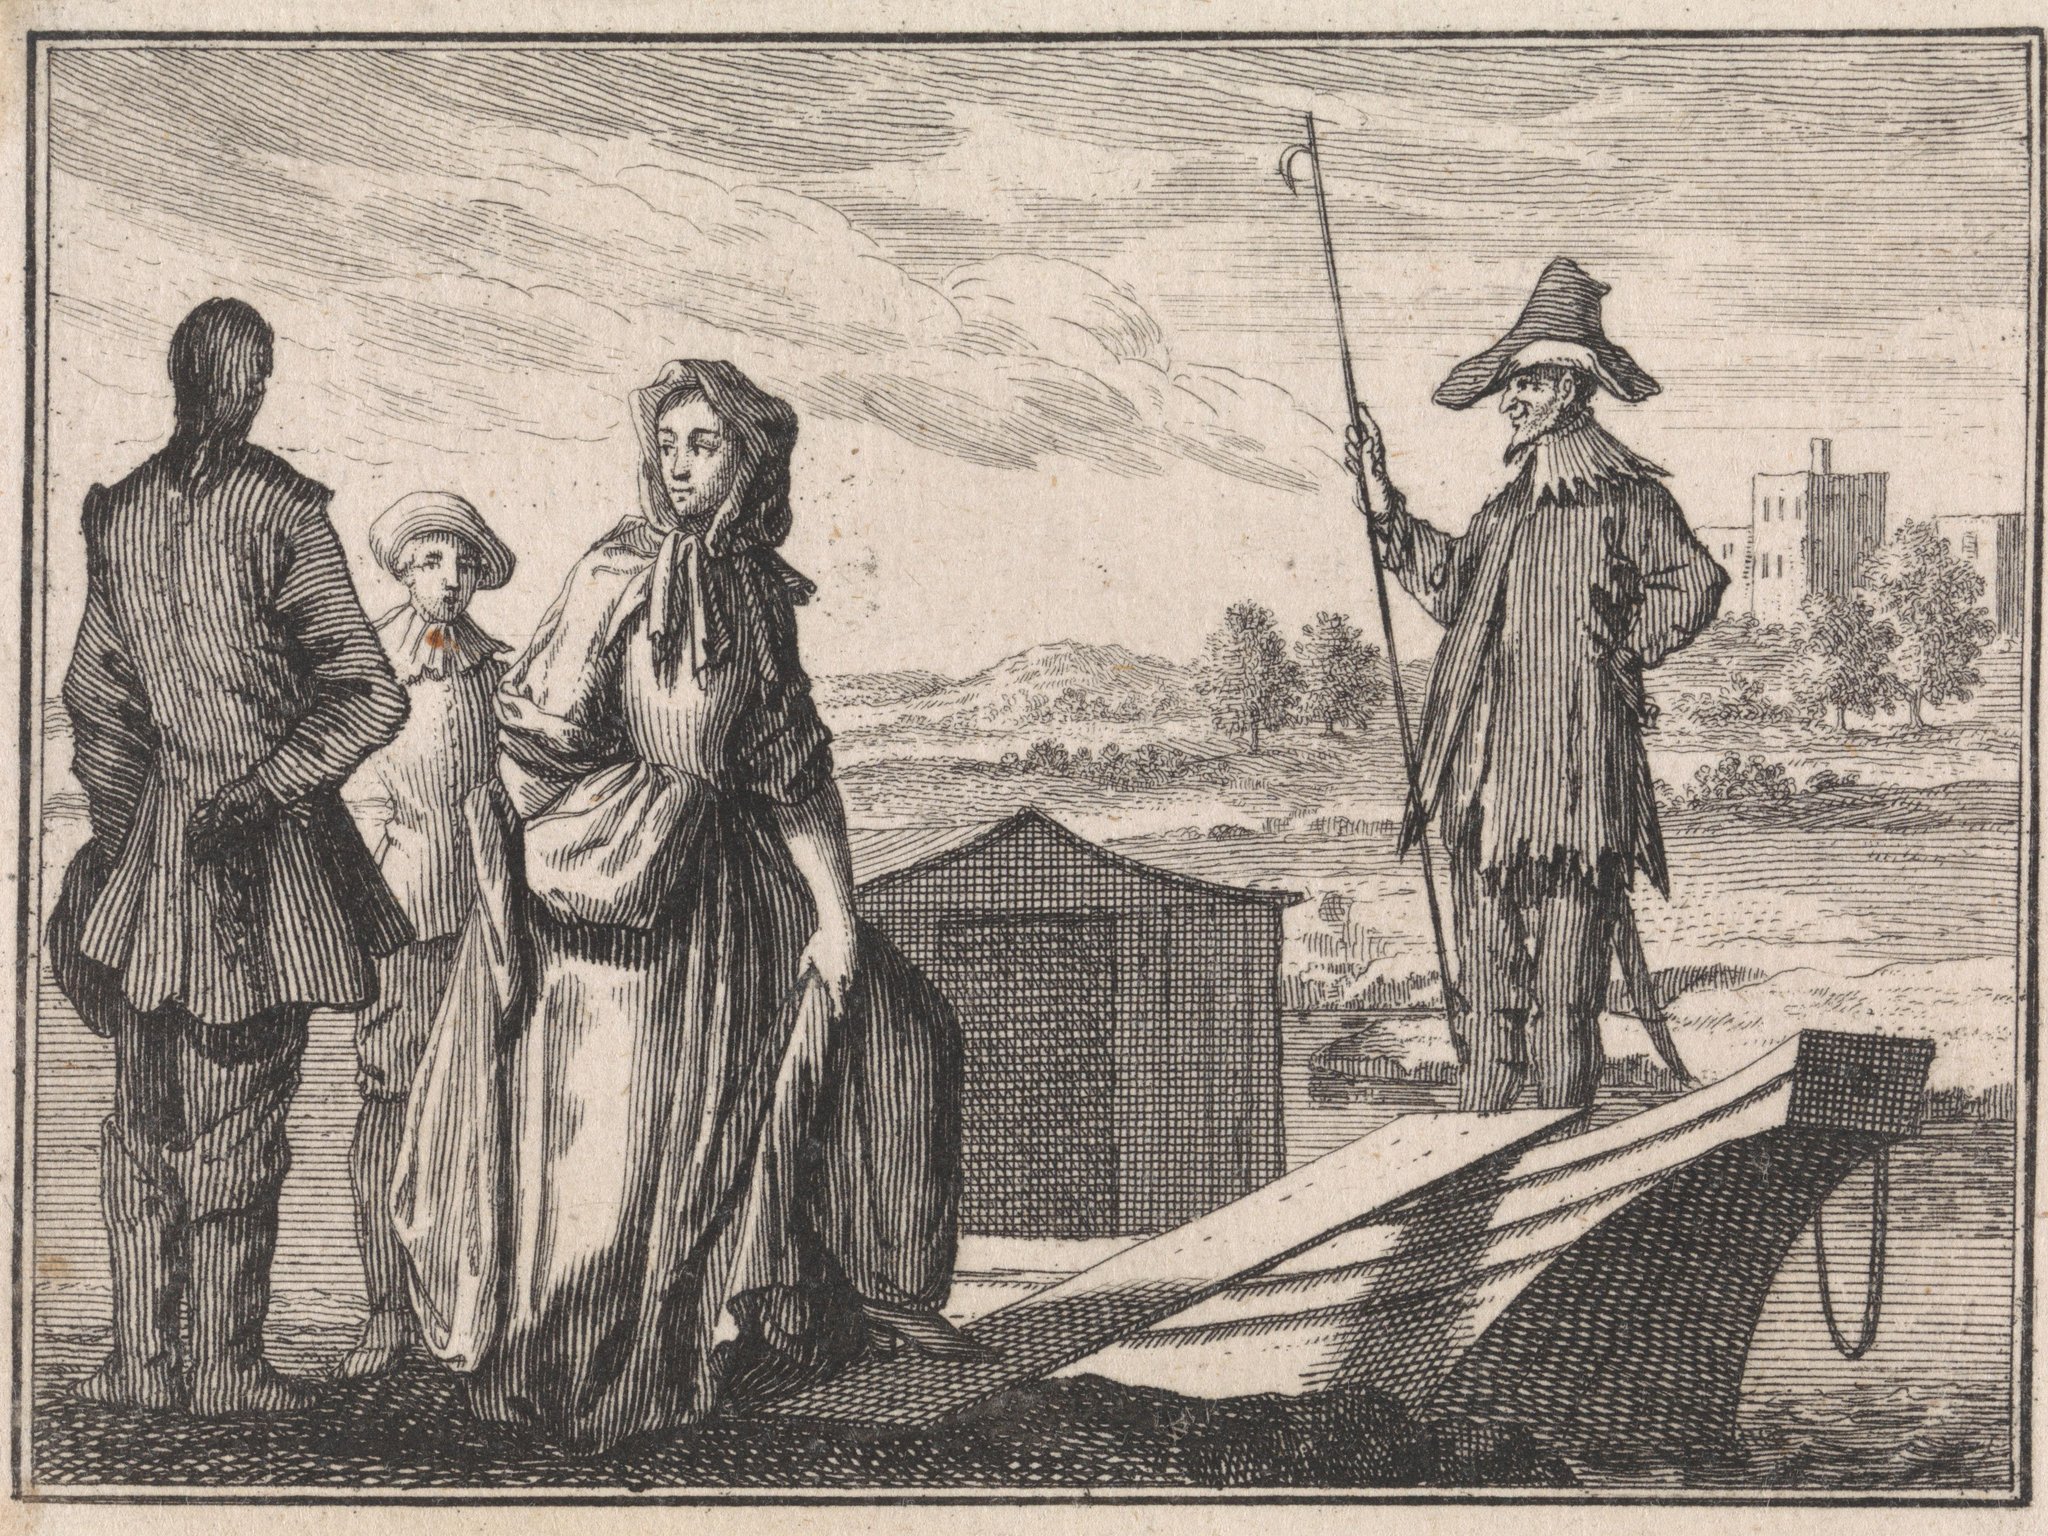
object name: book illustration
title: Numero 7 ein guldene Zahl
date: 1710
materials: paper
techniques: etching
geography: nuremberg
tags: devil(s) and demons, boat propelled by man or animal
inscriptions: collector's mark: Lugt 240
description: Illustratie uit: Abraham a Sancta Clara. Heilsames Gemisch Gemasch, das ist: Allerley seltsame und verwunderliche Geschichten (...). Neurenberg: Christoph Weigel, 1710, p. 385.